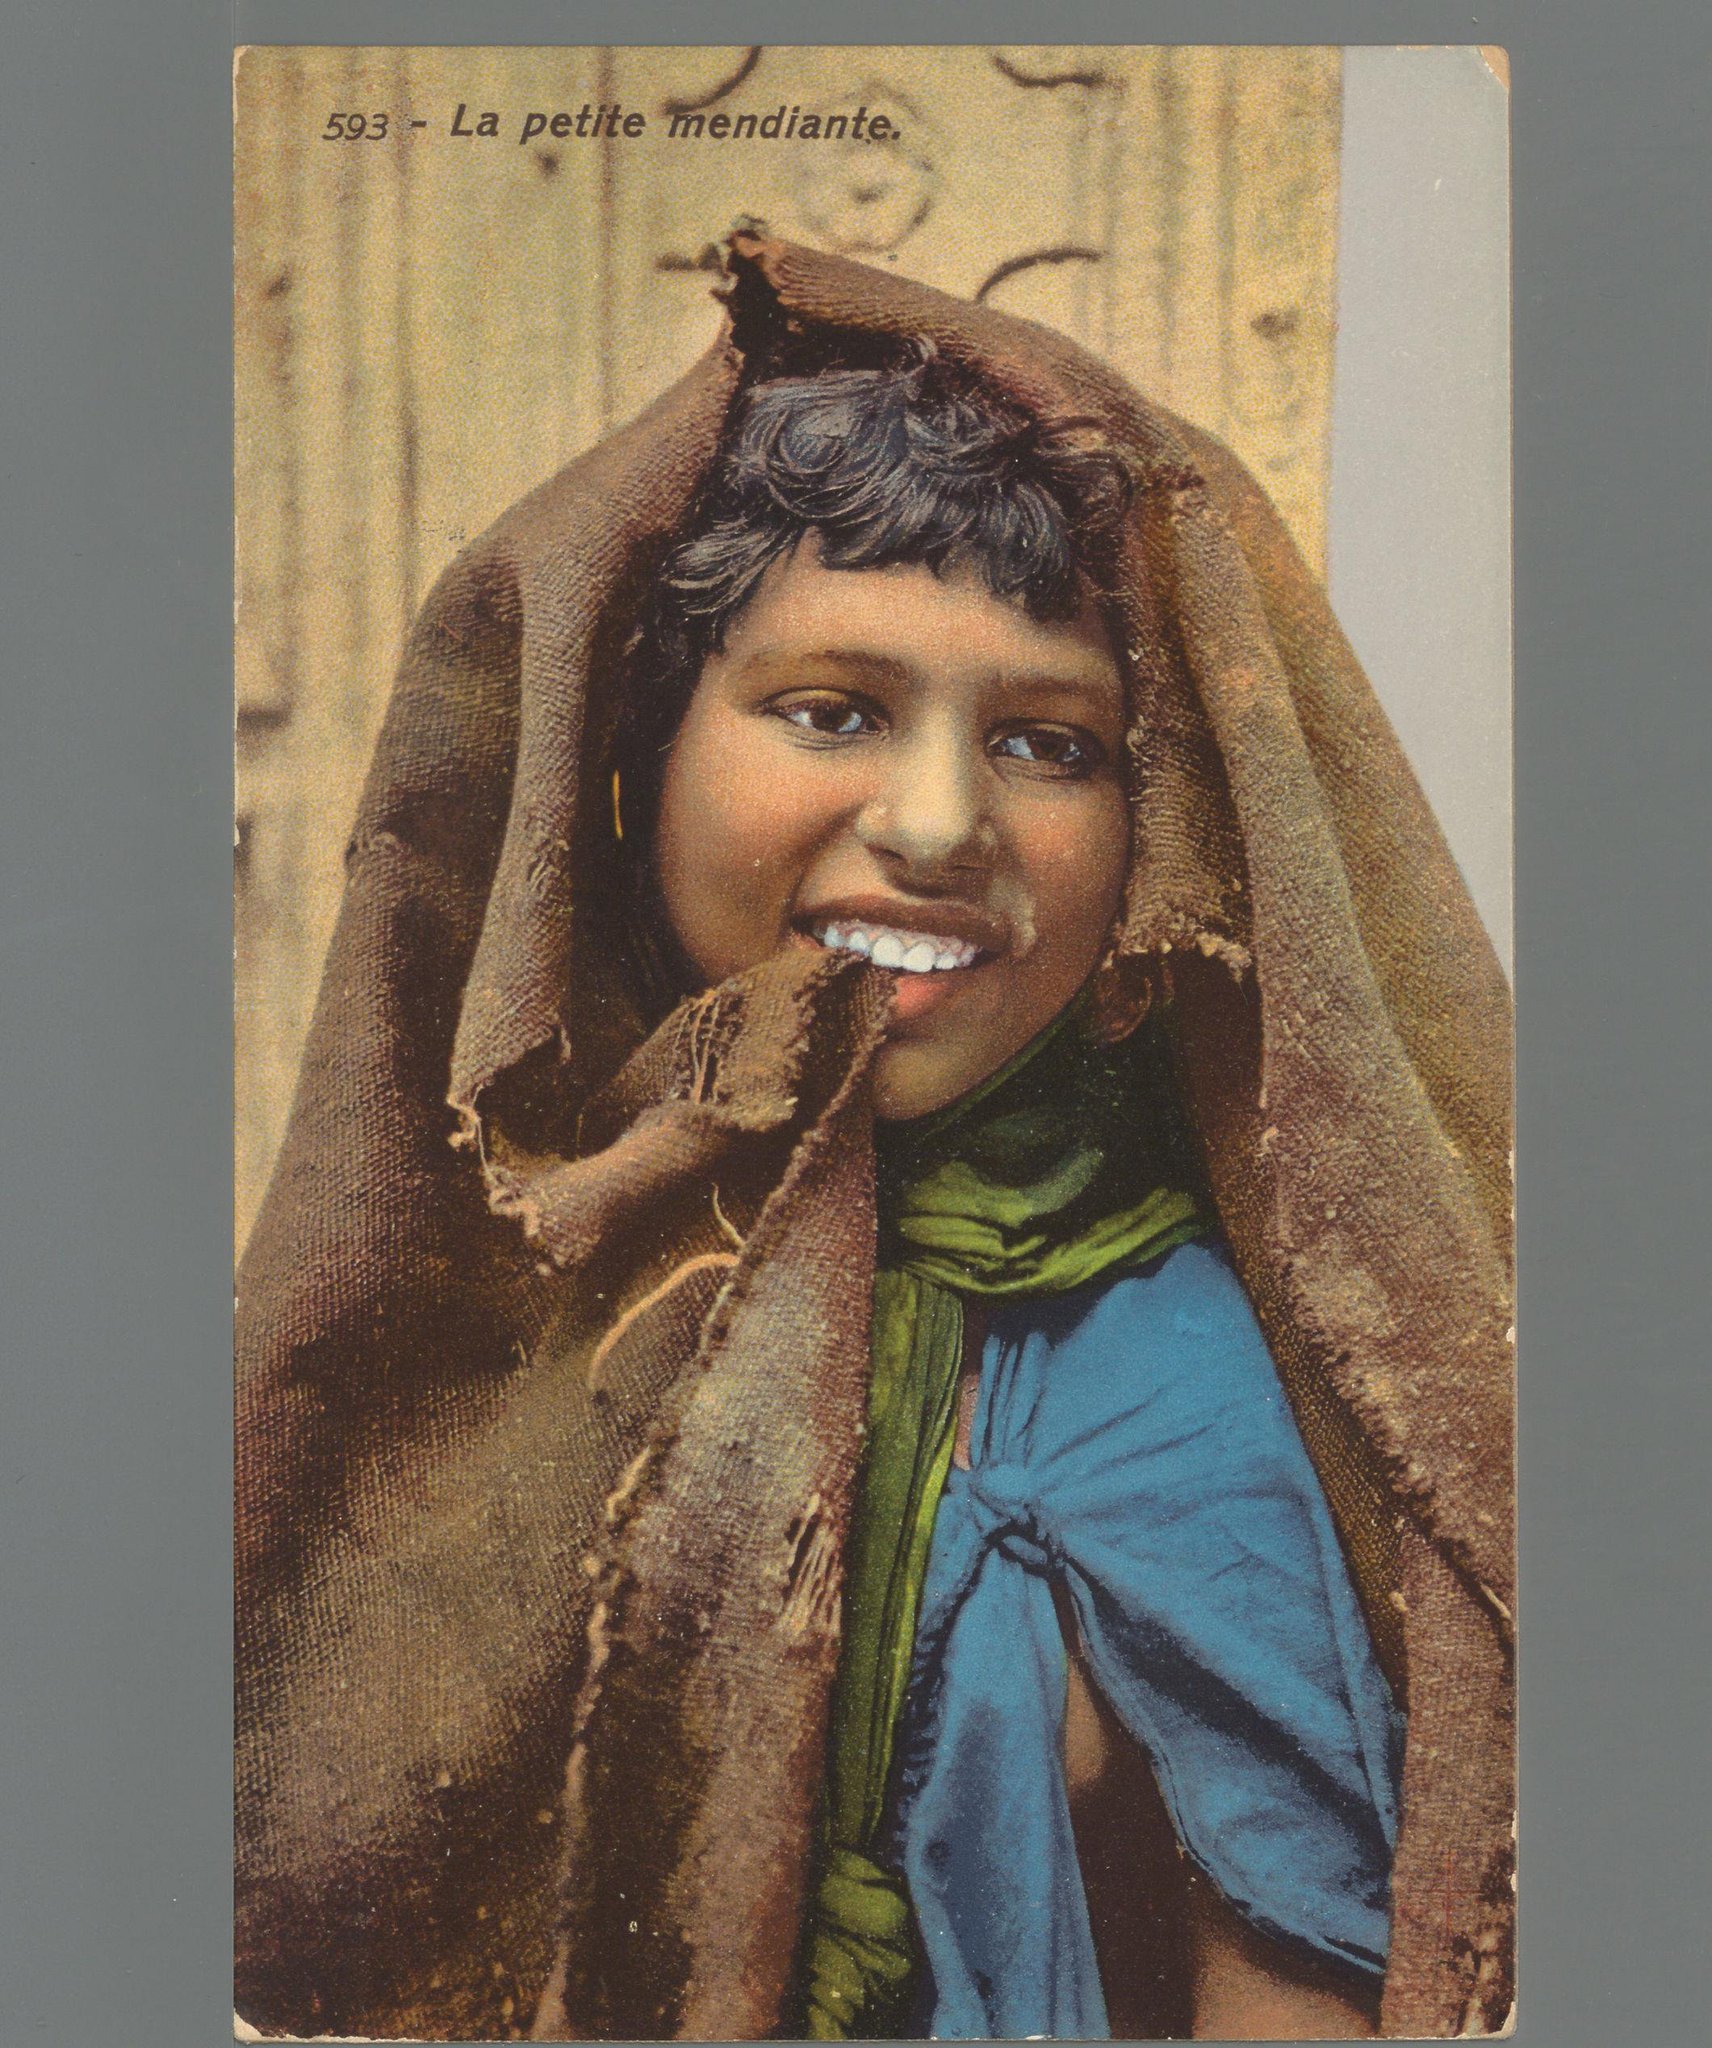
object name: photomechanical print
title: La petite mendiante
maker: Anonymous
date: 1903-1930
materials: cardboard, photographic process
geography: tunisia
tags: beggar